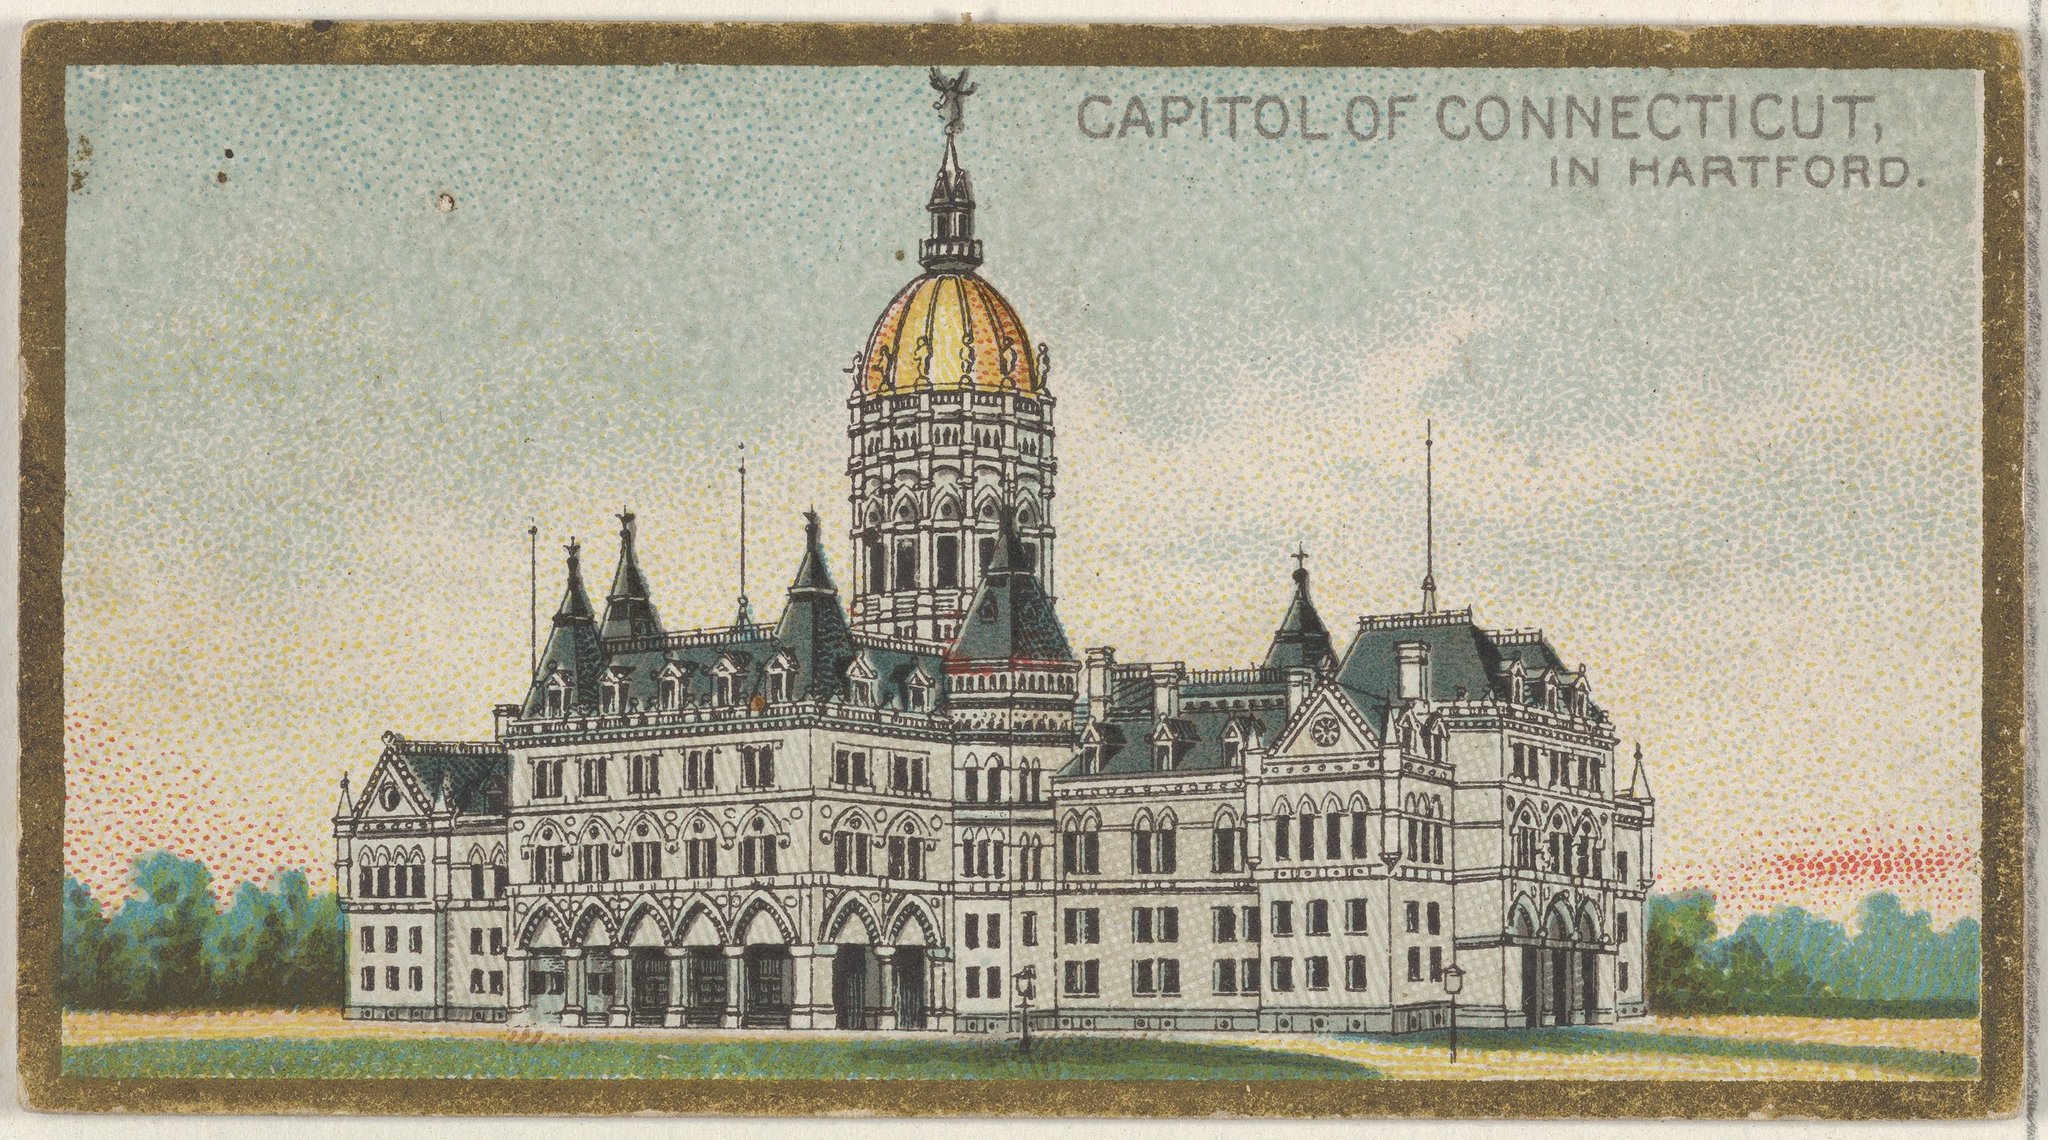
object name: print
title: Capitol of Connecticut in Hartford, from the General Government and State Capitol Buildings series (N14) for Allen & Ginter Cigarettes Brands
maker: allen & ginter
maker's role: publisher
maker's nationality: american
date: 1889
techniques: color lithograph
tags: buildings